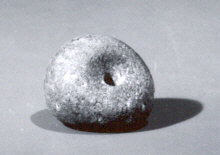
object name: ornament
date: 2333-2001 BCE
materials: faience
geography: mesopotamia